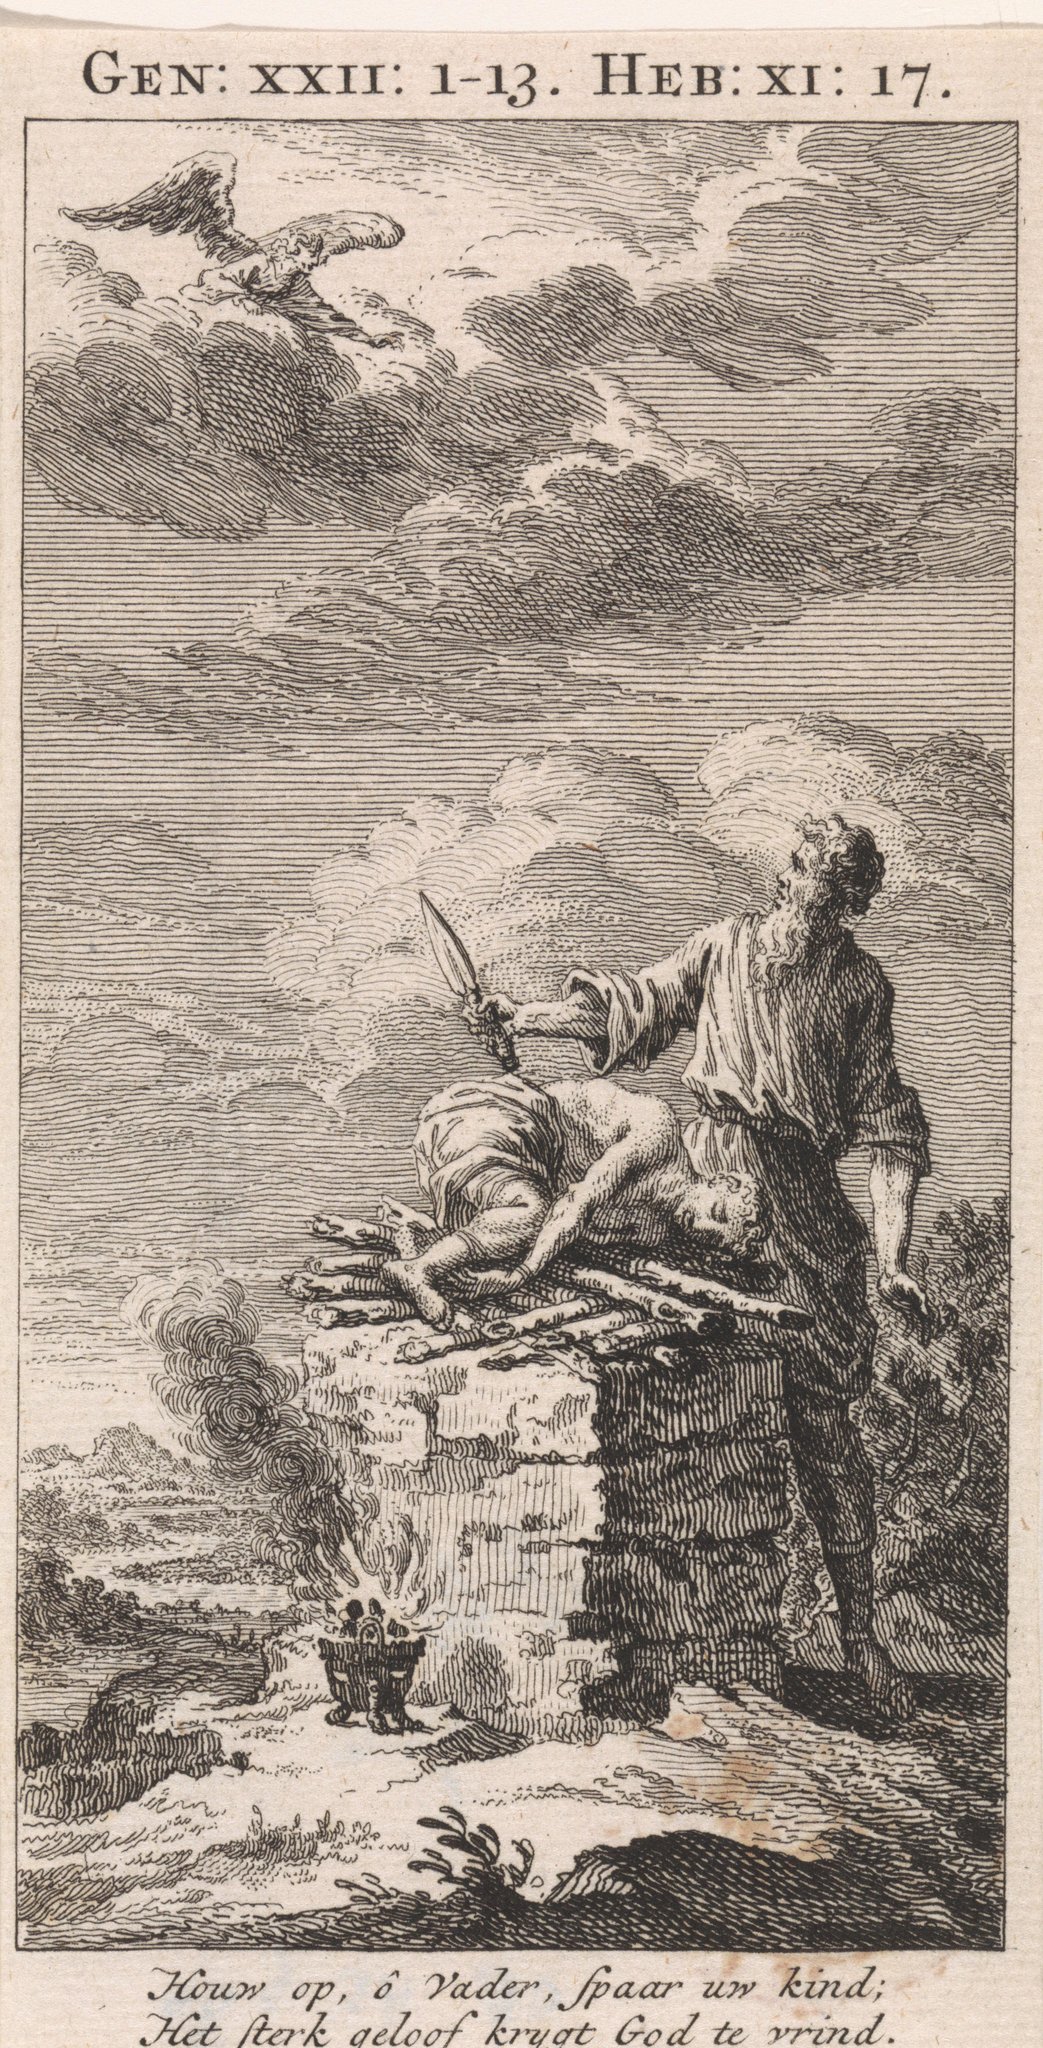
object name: print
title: Offer van Abraham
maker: jan luyken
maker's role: draughtsman, print maker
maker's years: 1649-1712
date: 1712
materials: paper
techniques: etching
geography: amsterdam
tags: abraham picks up the knife to kill isaac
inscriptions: collector's mark: Lugt 240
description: Variant op illustratie voor: Luyken, Jan. Bybel printen. Amsterdam: Pieter Arentsz. II (wed.) en Cornelis van der Sys, 1712, p. 4.